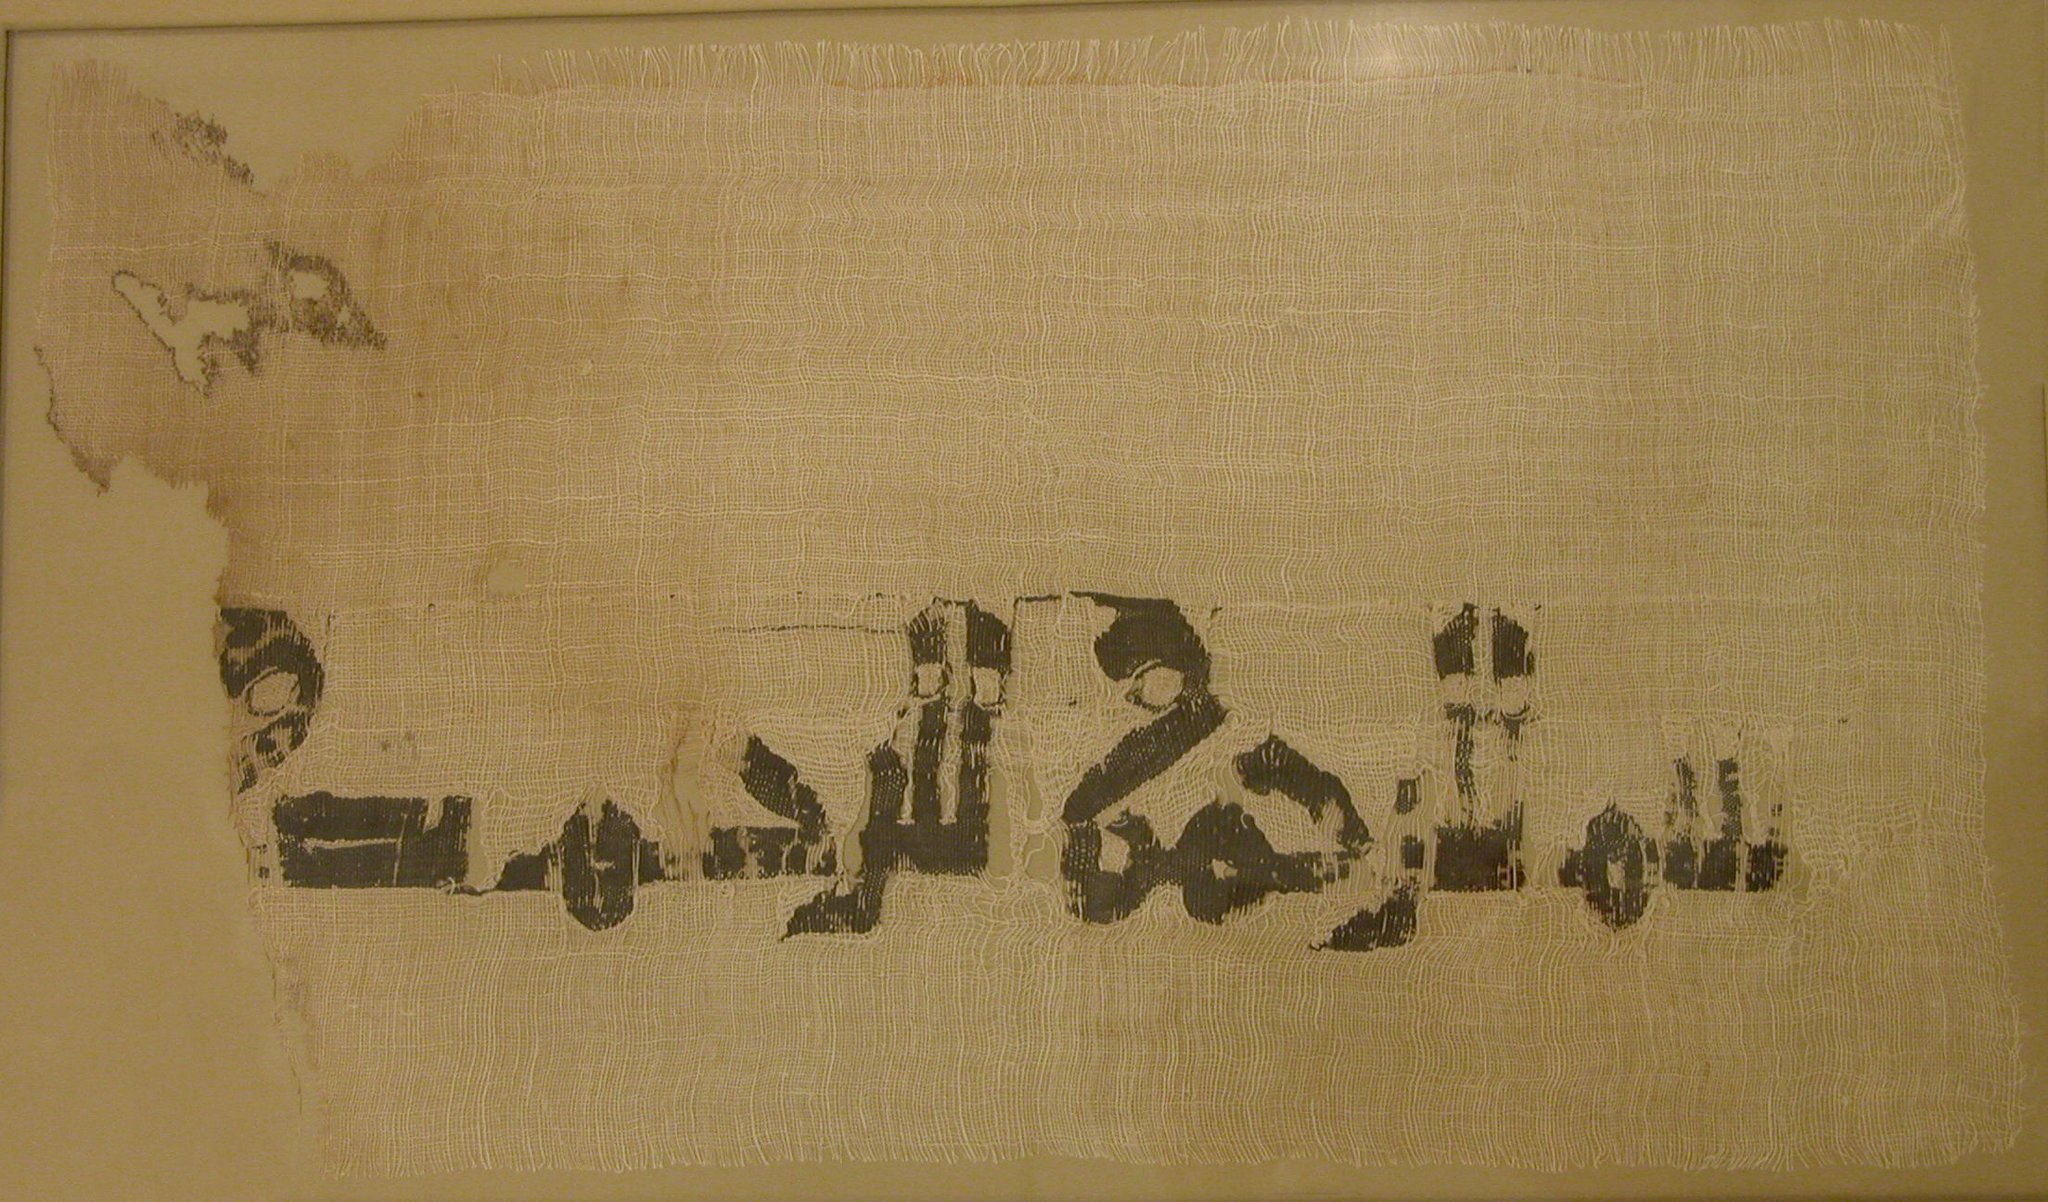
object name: textile fragment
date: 901-1100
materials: linen, silk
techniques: weave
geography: egypt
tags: arabic